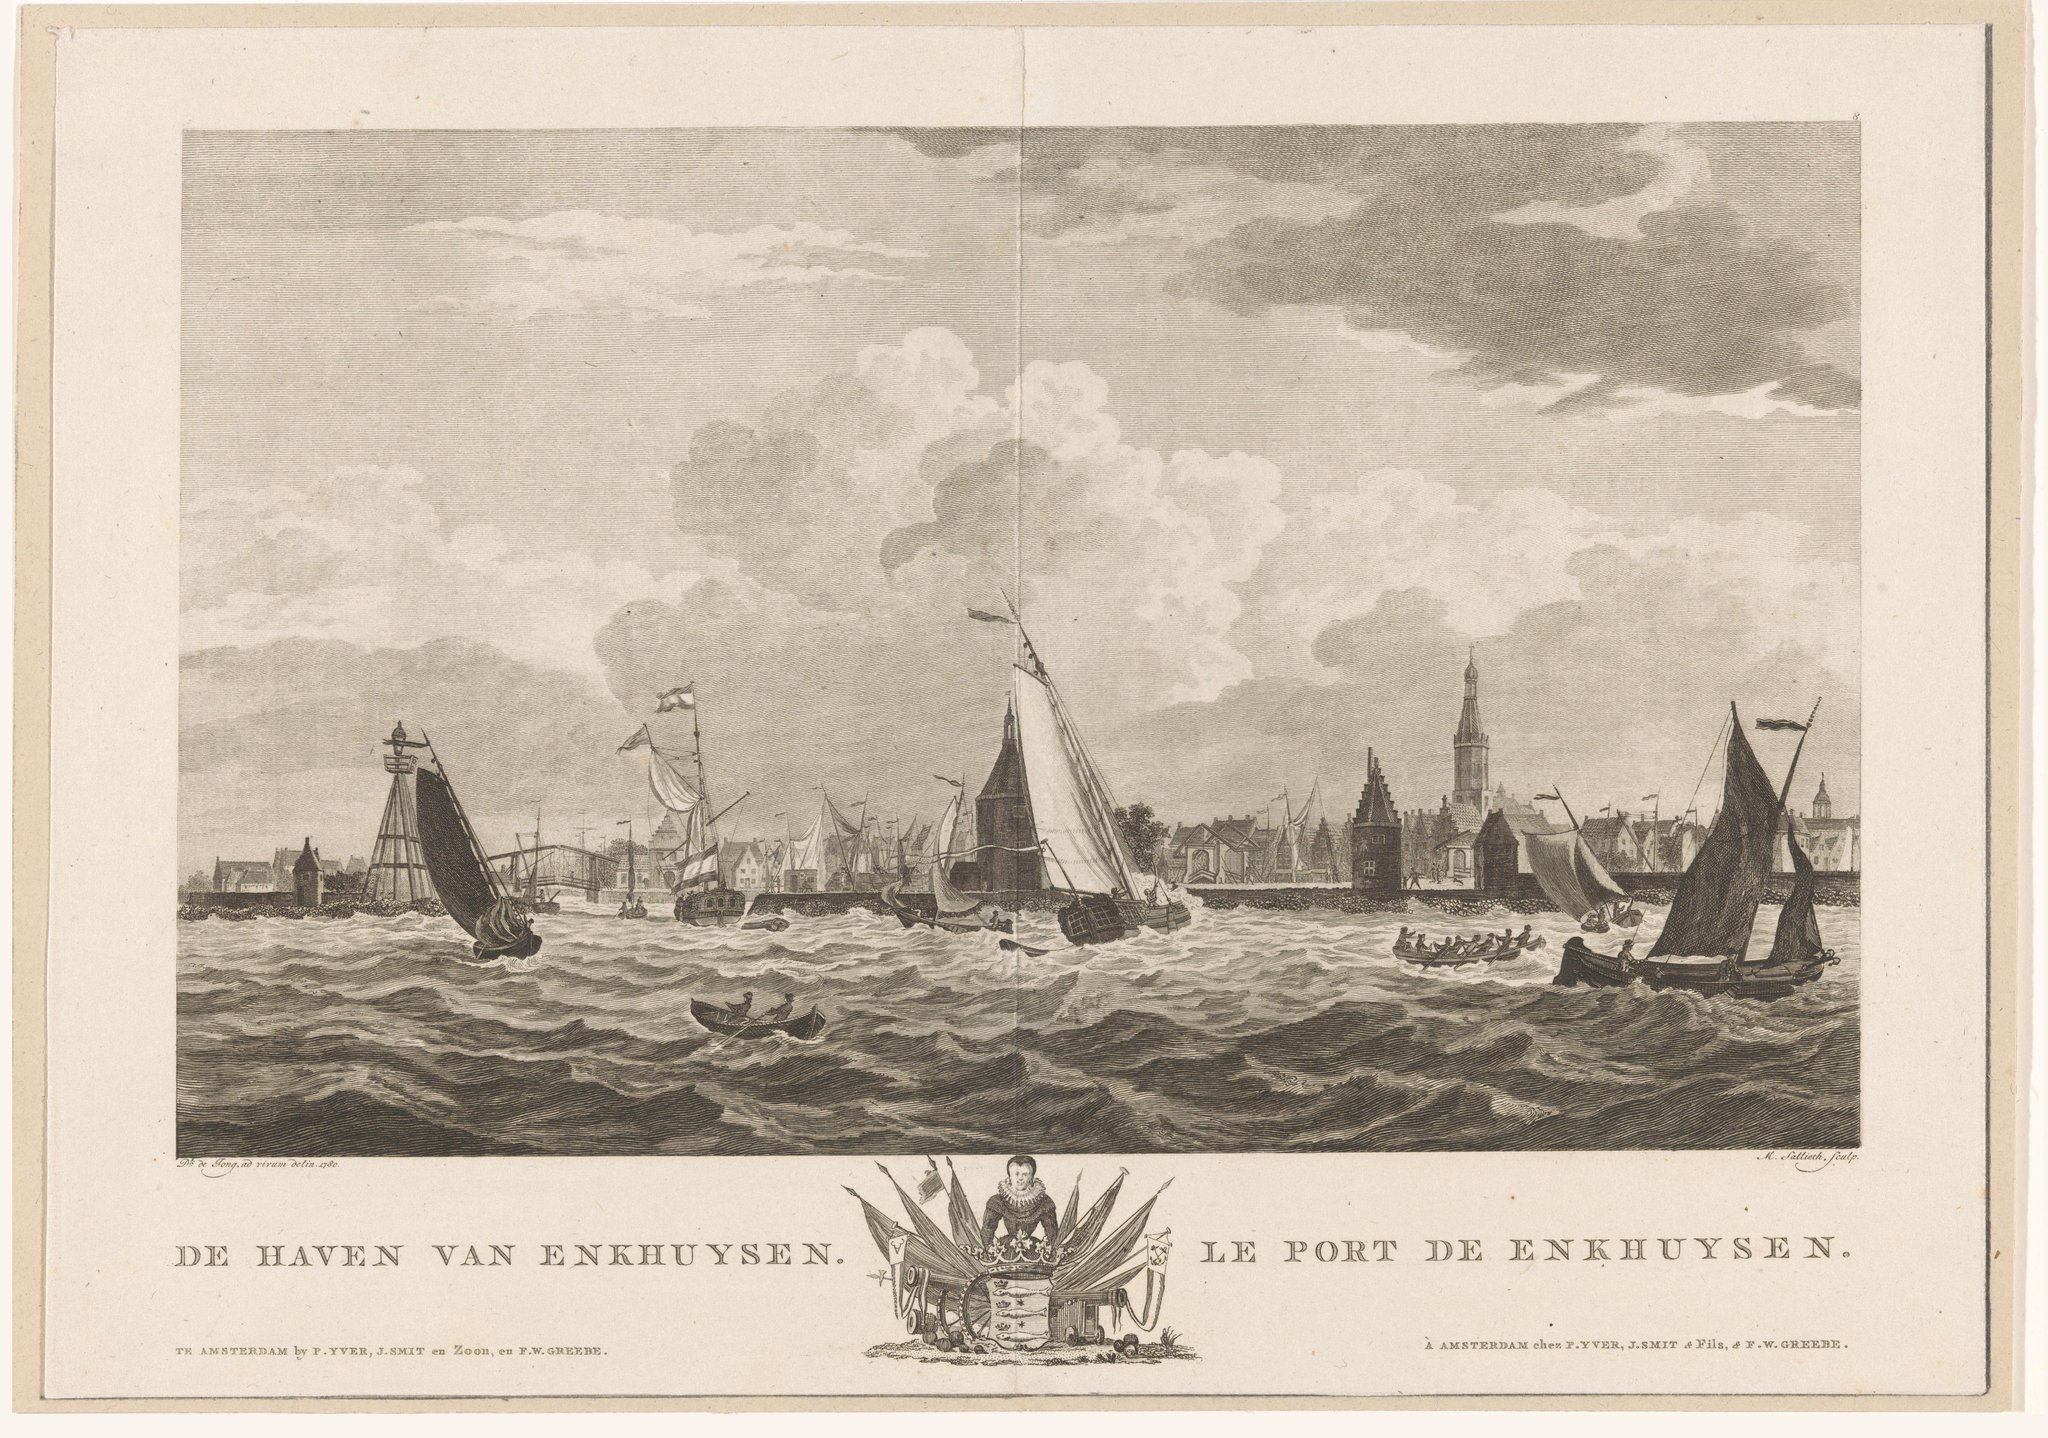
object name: print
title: De haven van Enkhuysen / Le port de Enkhuysen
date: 1780-1787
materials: paper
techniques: etching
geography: amsterdam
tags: harbour, coat of arms (as symbol of the state, etc.) (+ city; municipal), sailing-ship, sailing-boat, enkhuizen, zuiderzee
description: Latere staat ook gebruikt in: Aa, Cornelis van der. Atlas van de zeehavens der Bataafsche Republiek. Met derzelver beschrijvingen in XXXI kunstplaaten / Atlas van de zeehavens der Bataafsche Republiek, die van Batavia en Onrust. Mitsgaders de afbeeldingen van de haringvisscherij en de walvischvangst (…). Amsterdam: Evert Maaskamp, 1805.